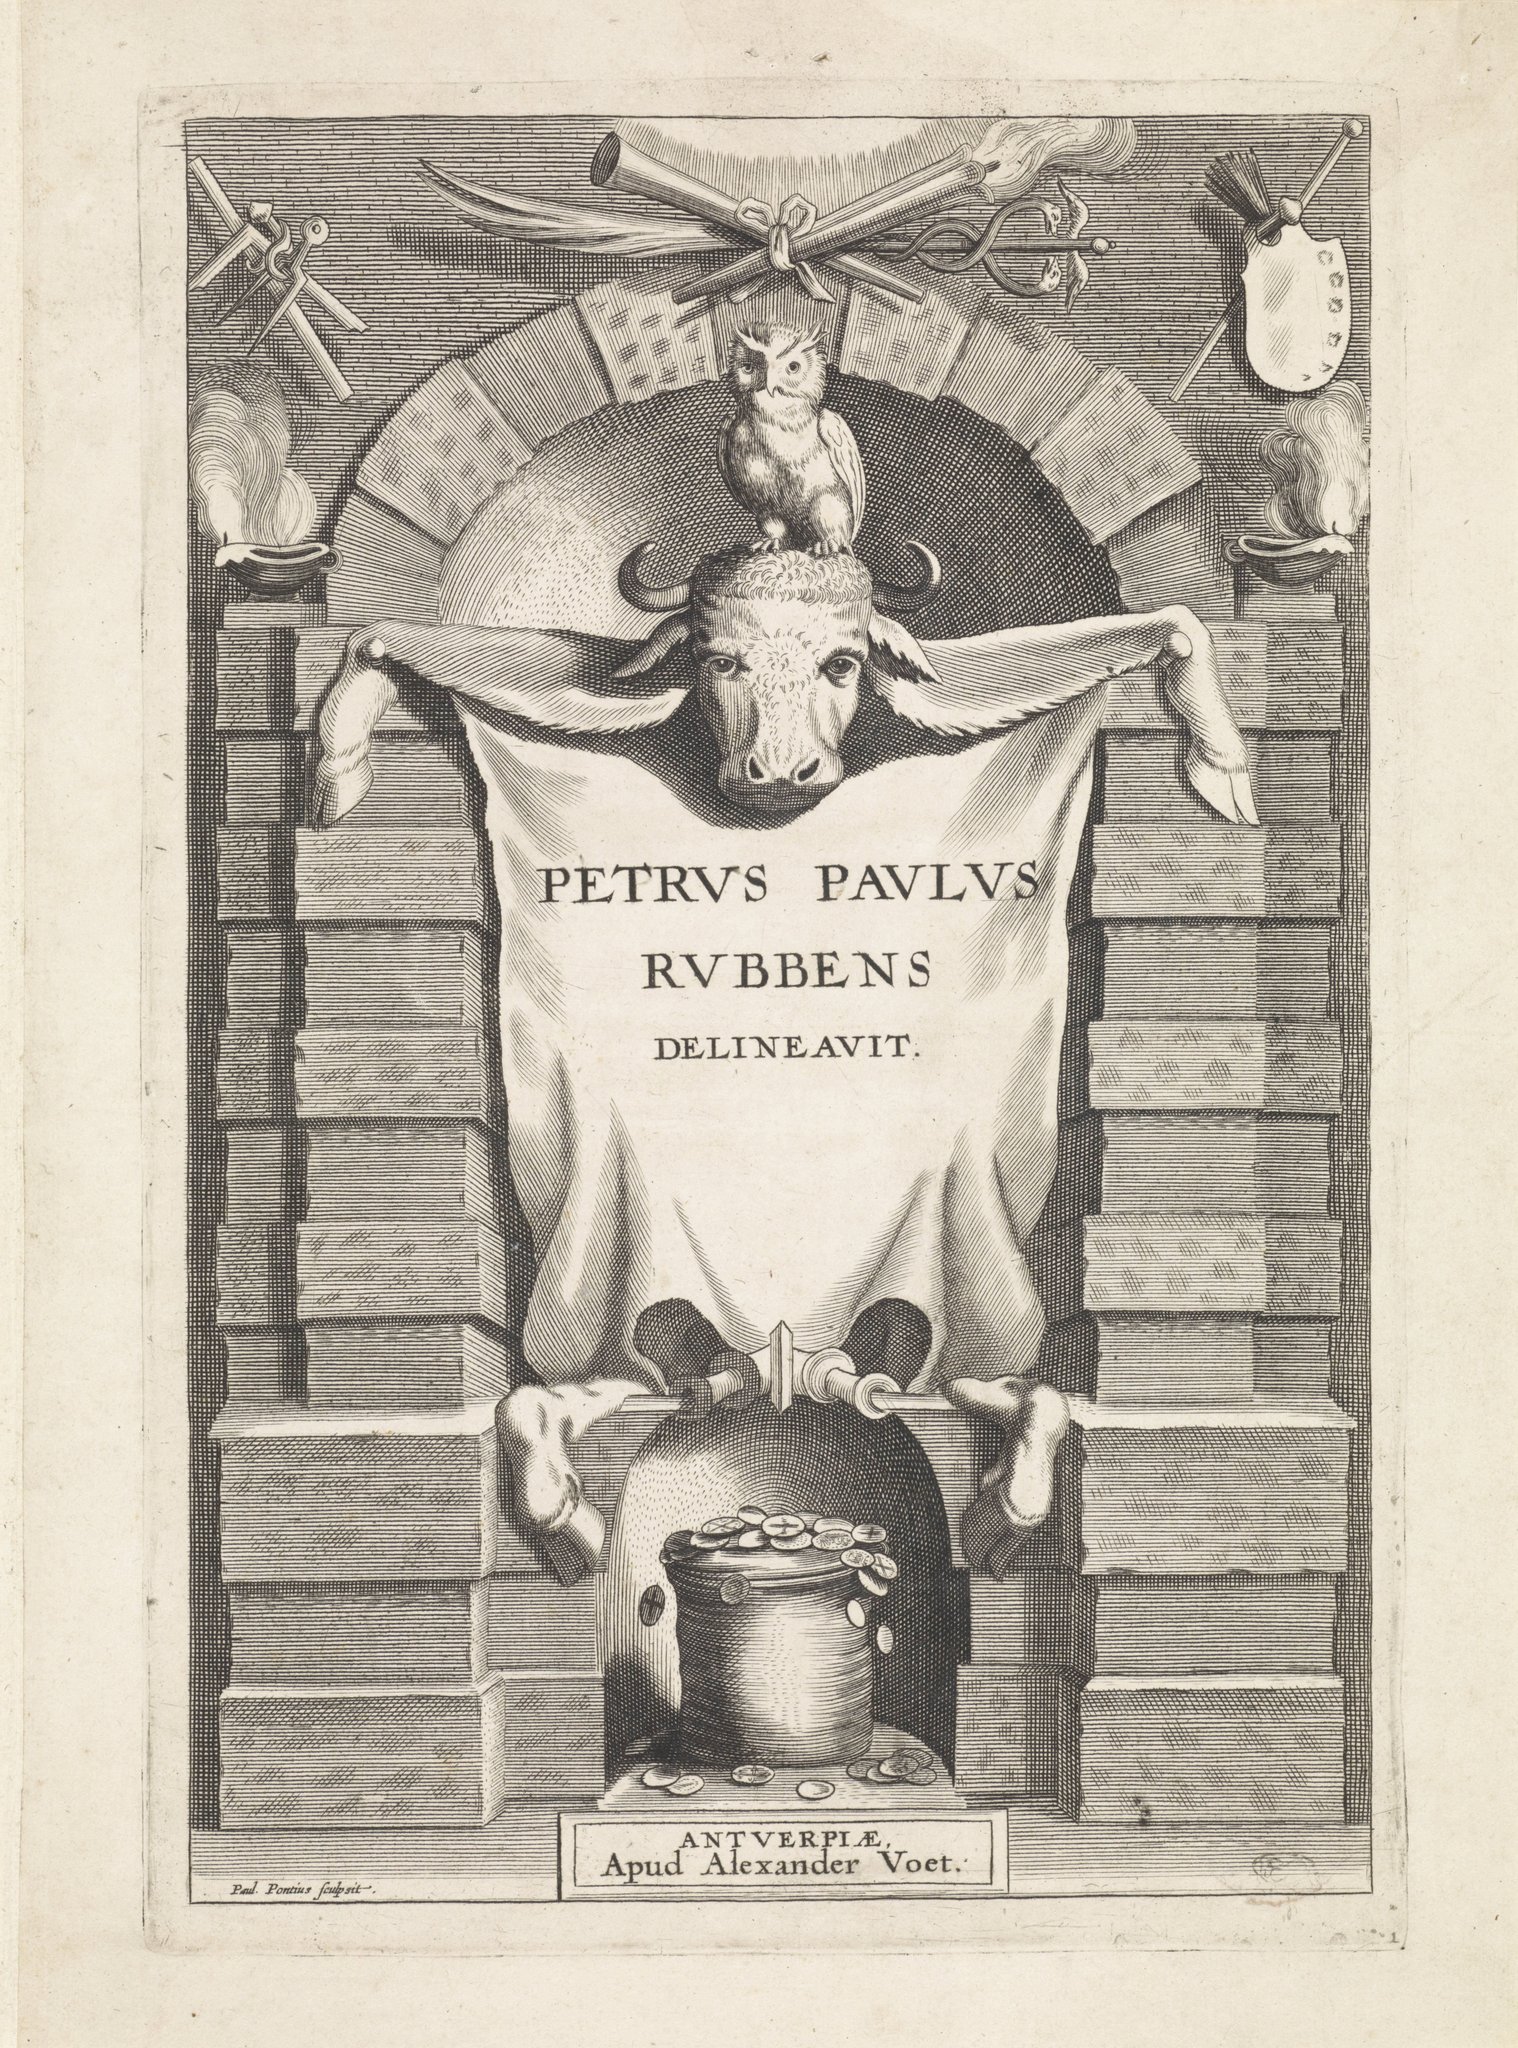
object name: titelprent, frontispice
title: Het tekenboek van Peter Paul Rubens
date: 1616-1657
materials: paper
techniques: engraving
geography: antwerp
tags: coin, symbolic representations, allegories and emblems ~ art; 'arte' (ripa), attributes of minerva: owl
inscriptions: number: ‘1’, collector's mark: Lugt 240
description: Een architecturale nis met een stierenhuid waarop de titel in het Latijn. Op de kop van de stier zit een uil, het attribuut van Minerva als patrones van de kunsten. Boven de nis hangen diverse attributen die de kunsten symboliseren. Op de grond staat een zak met munten.